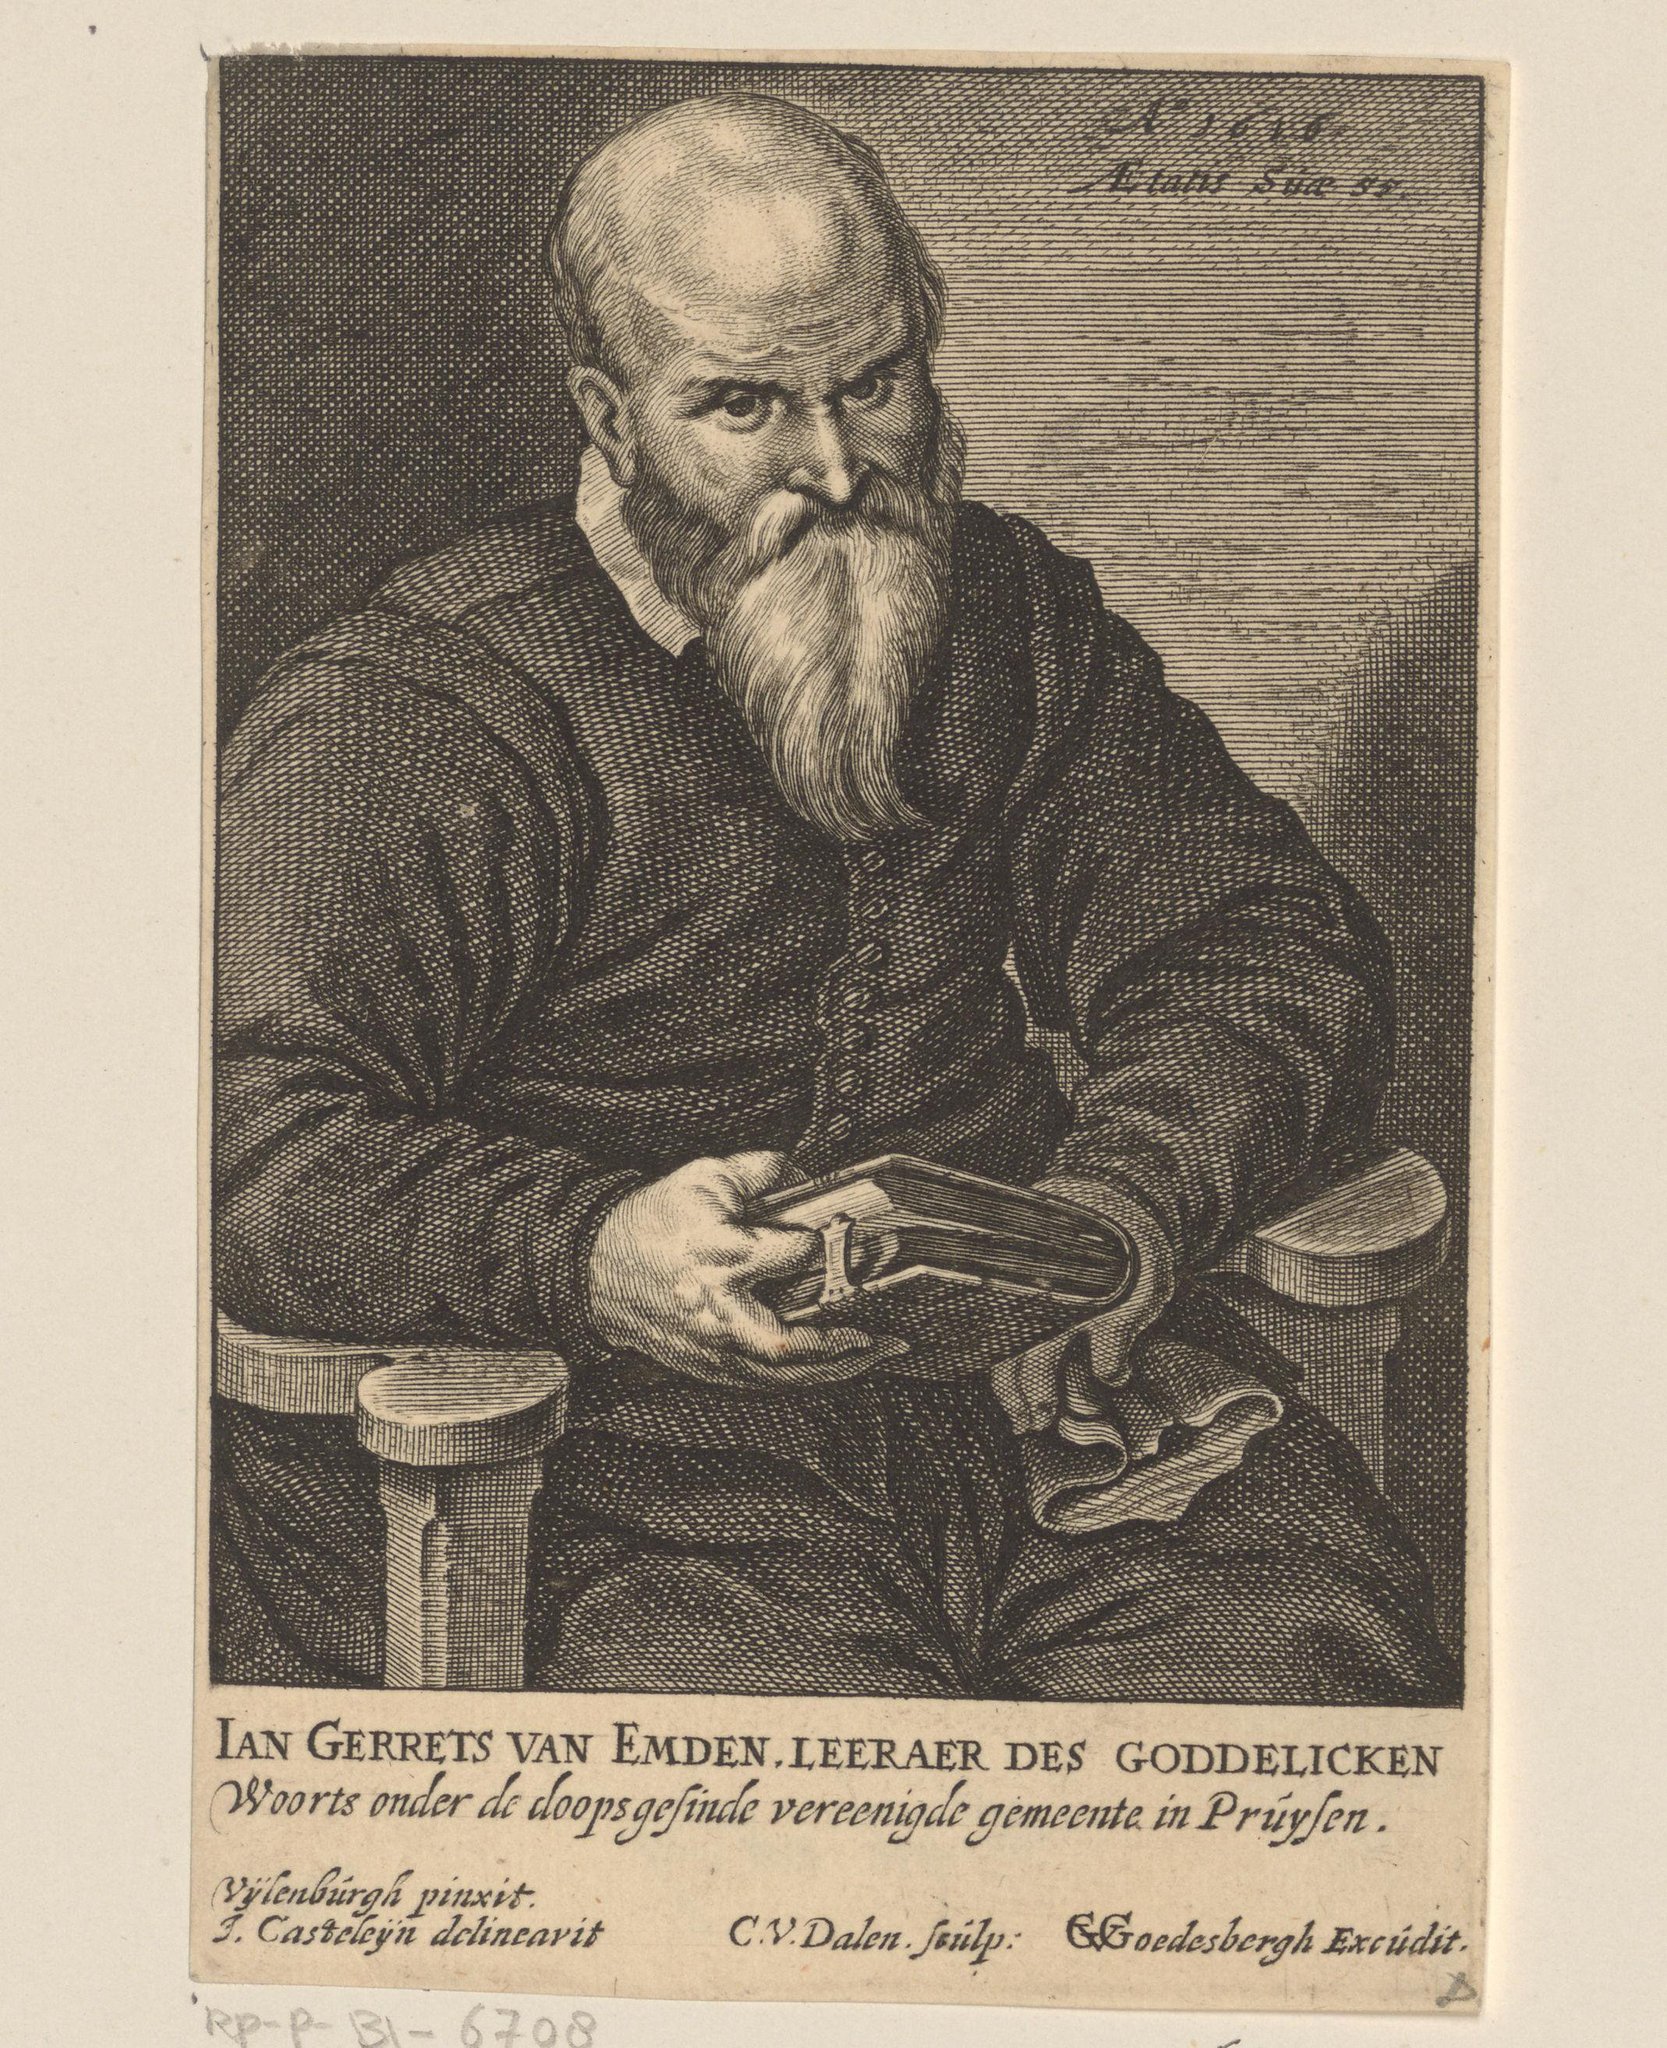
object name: print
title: Portret van Jan Gerrits van Emden op 55-jarige leeftijd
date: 1665-1702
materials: paper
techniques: engraving, etching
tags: theologian, historical persons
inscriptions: collector's mark: Lugt 2228, collector's mark: Lugt 2228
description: Tekst in het Nederlands in de ondermarge.